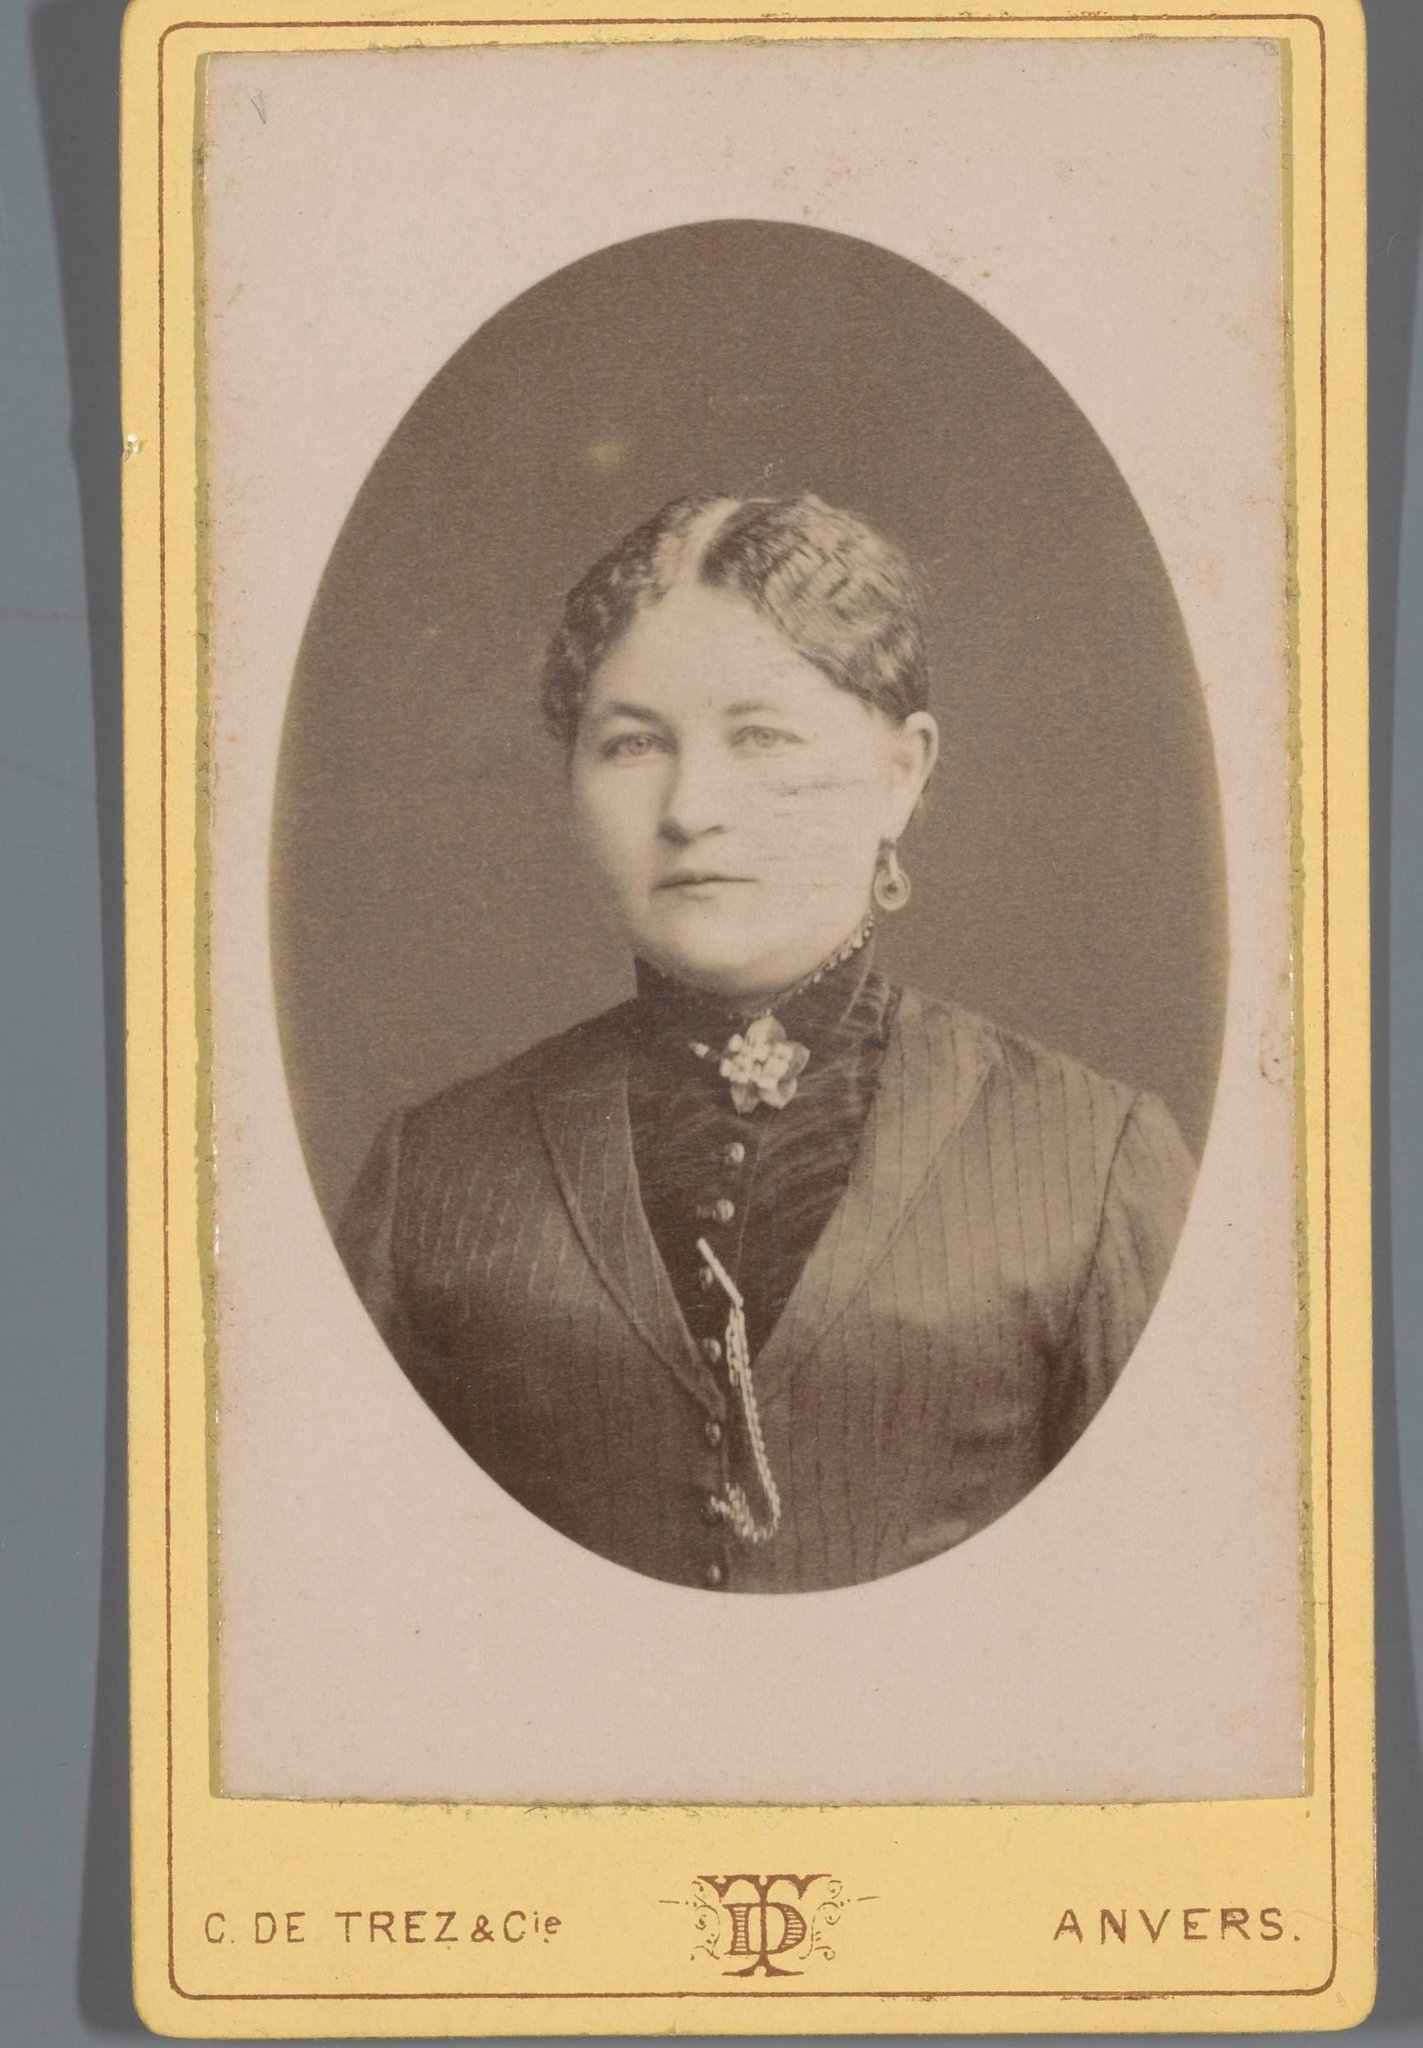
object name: photograph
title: Portret van een onbekende vrouw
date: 1885-1904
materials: cardboard, celluloid, paper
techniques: albumen print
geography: antwerp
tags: anonymous historical person portrayed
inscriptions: inscription: ‘Les Clichés sont conservés.’, address: ‘Rue du Vallon vert 28/ ANVERS/ Maison/ a/ BRUGES/ Rue Notre Dame 14/ Maison/ a/ BRUXELLES/ Rue du pont neuf No 1./ 1 et 3, Rue de la corne 1 et 3./ GAND’